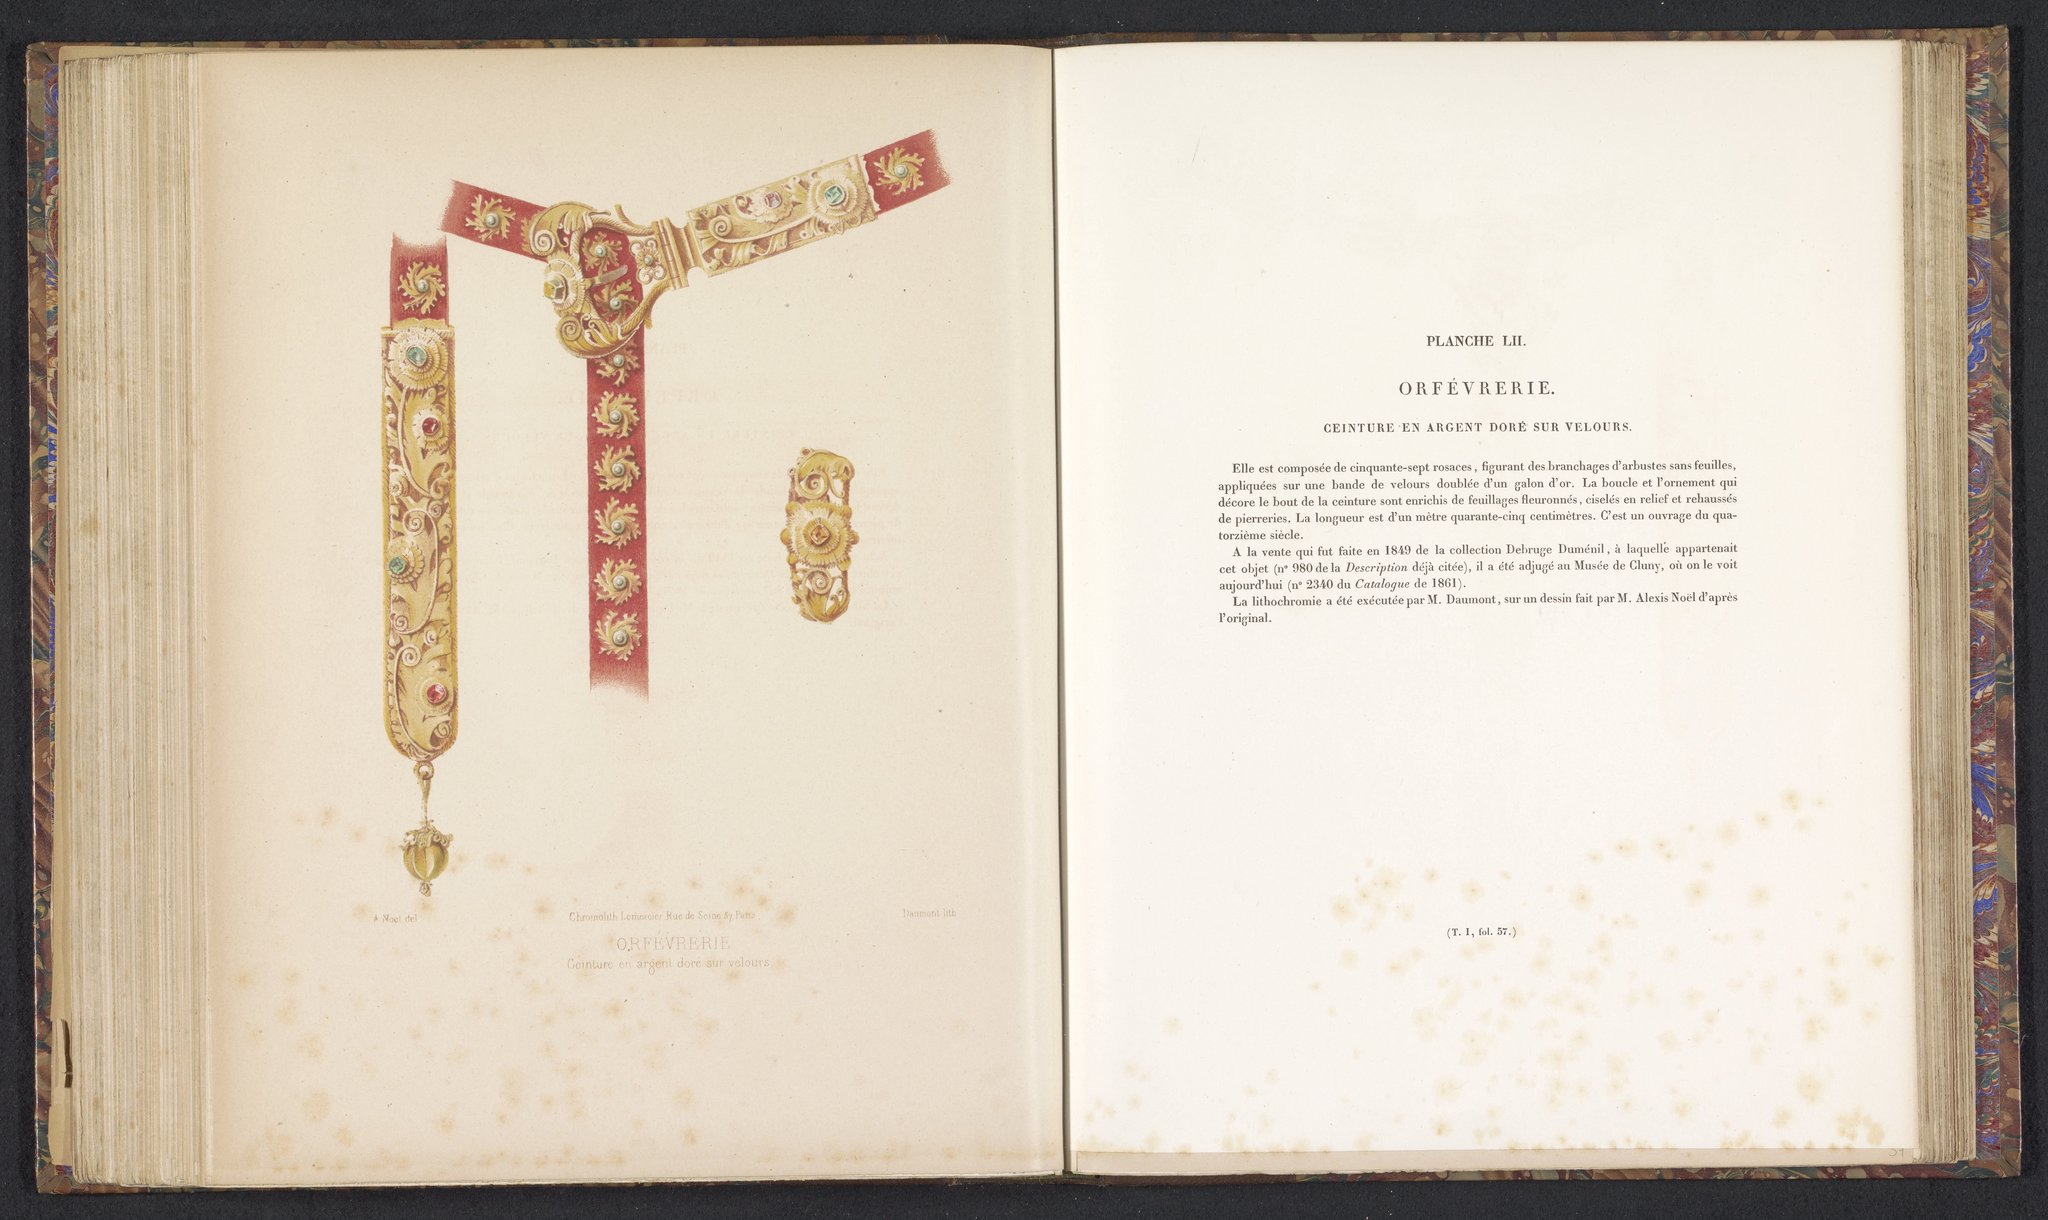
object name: page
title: Ceinture en argent doré sur velours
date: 1859-1864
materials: paper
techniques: chromolithography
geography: paris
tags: belt, girdle, waistband